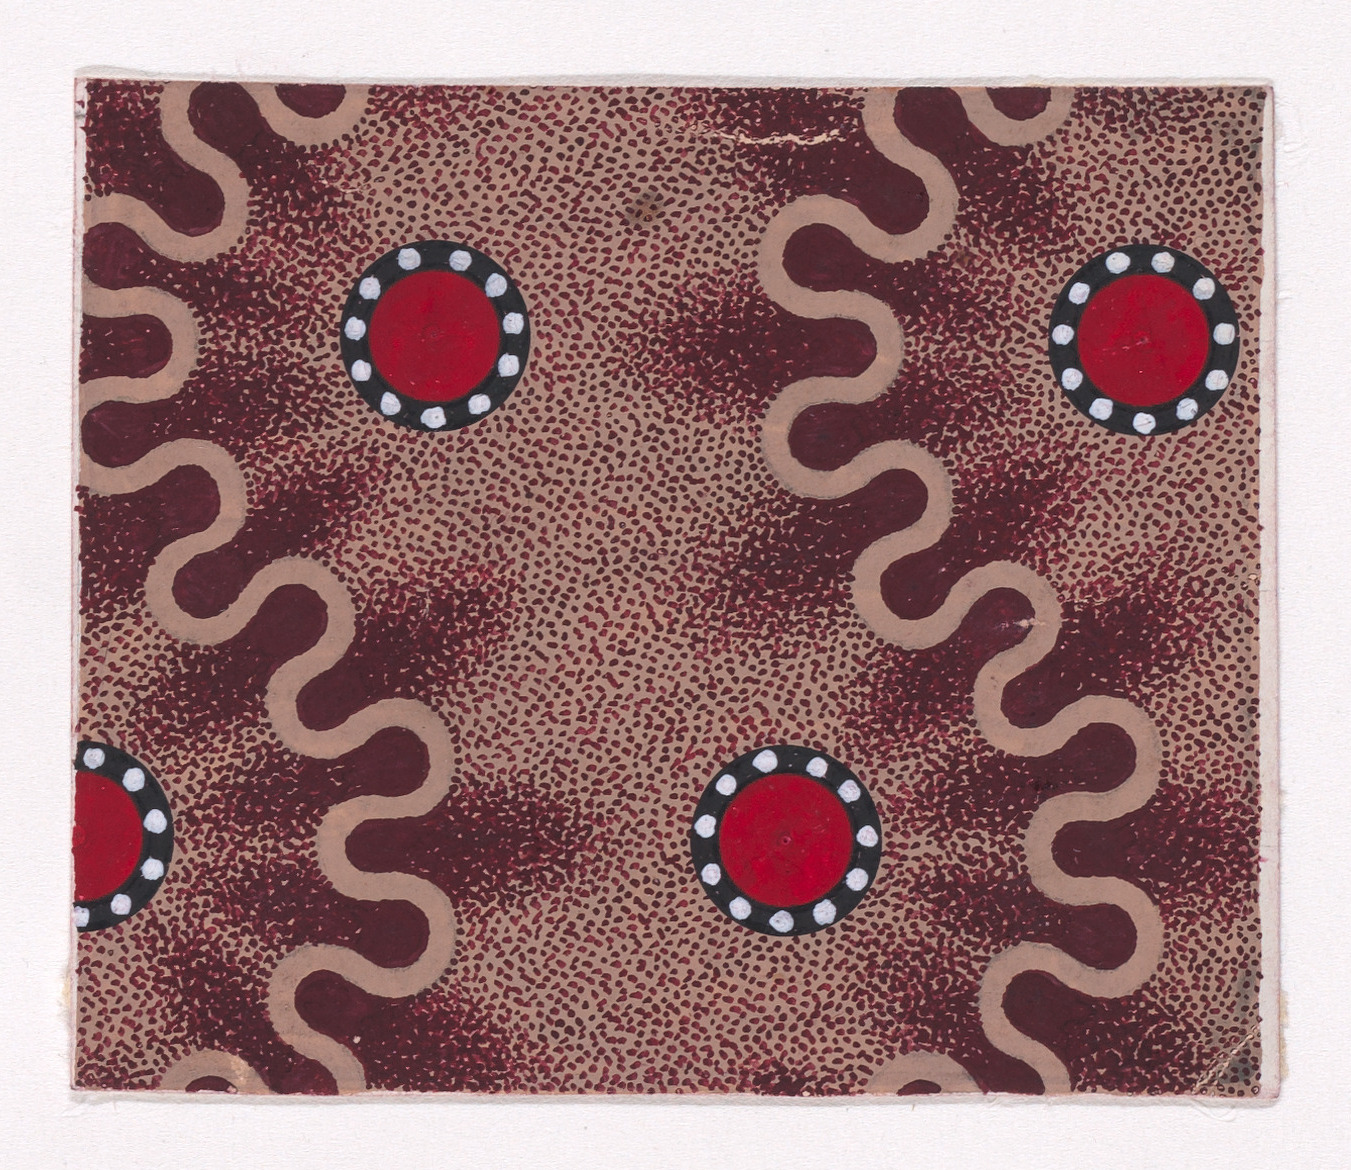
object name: drawing ornament architecture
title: Textile Design with a Stippled Background and Vertical Stripes of Alternating Circles of Framed by a Ribbon Adorned with Pearls Separated by Undulating Garlands of Ribbons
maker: anonymous, alsatian, 19th century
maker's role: artist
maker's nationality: alsatian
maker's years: 1800-1900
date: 1840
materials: gouache